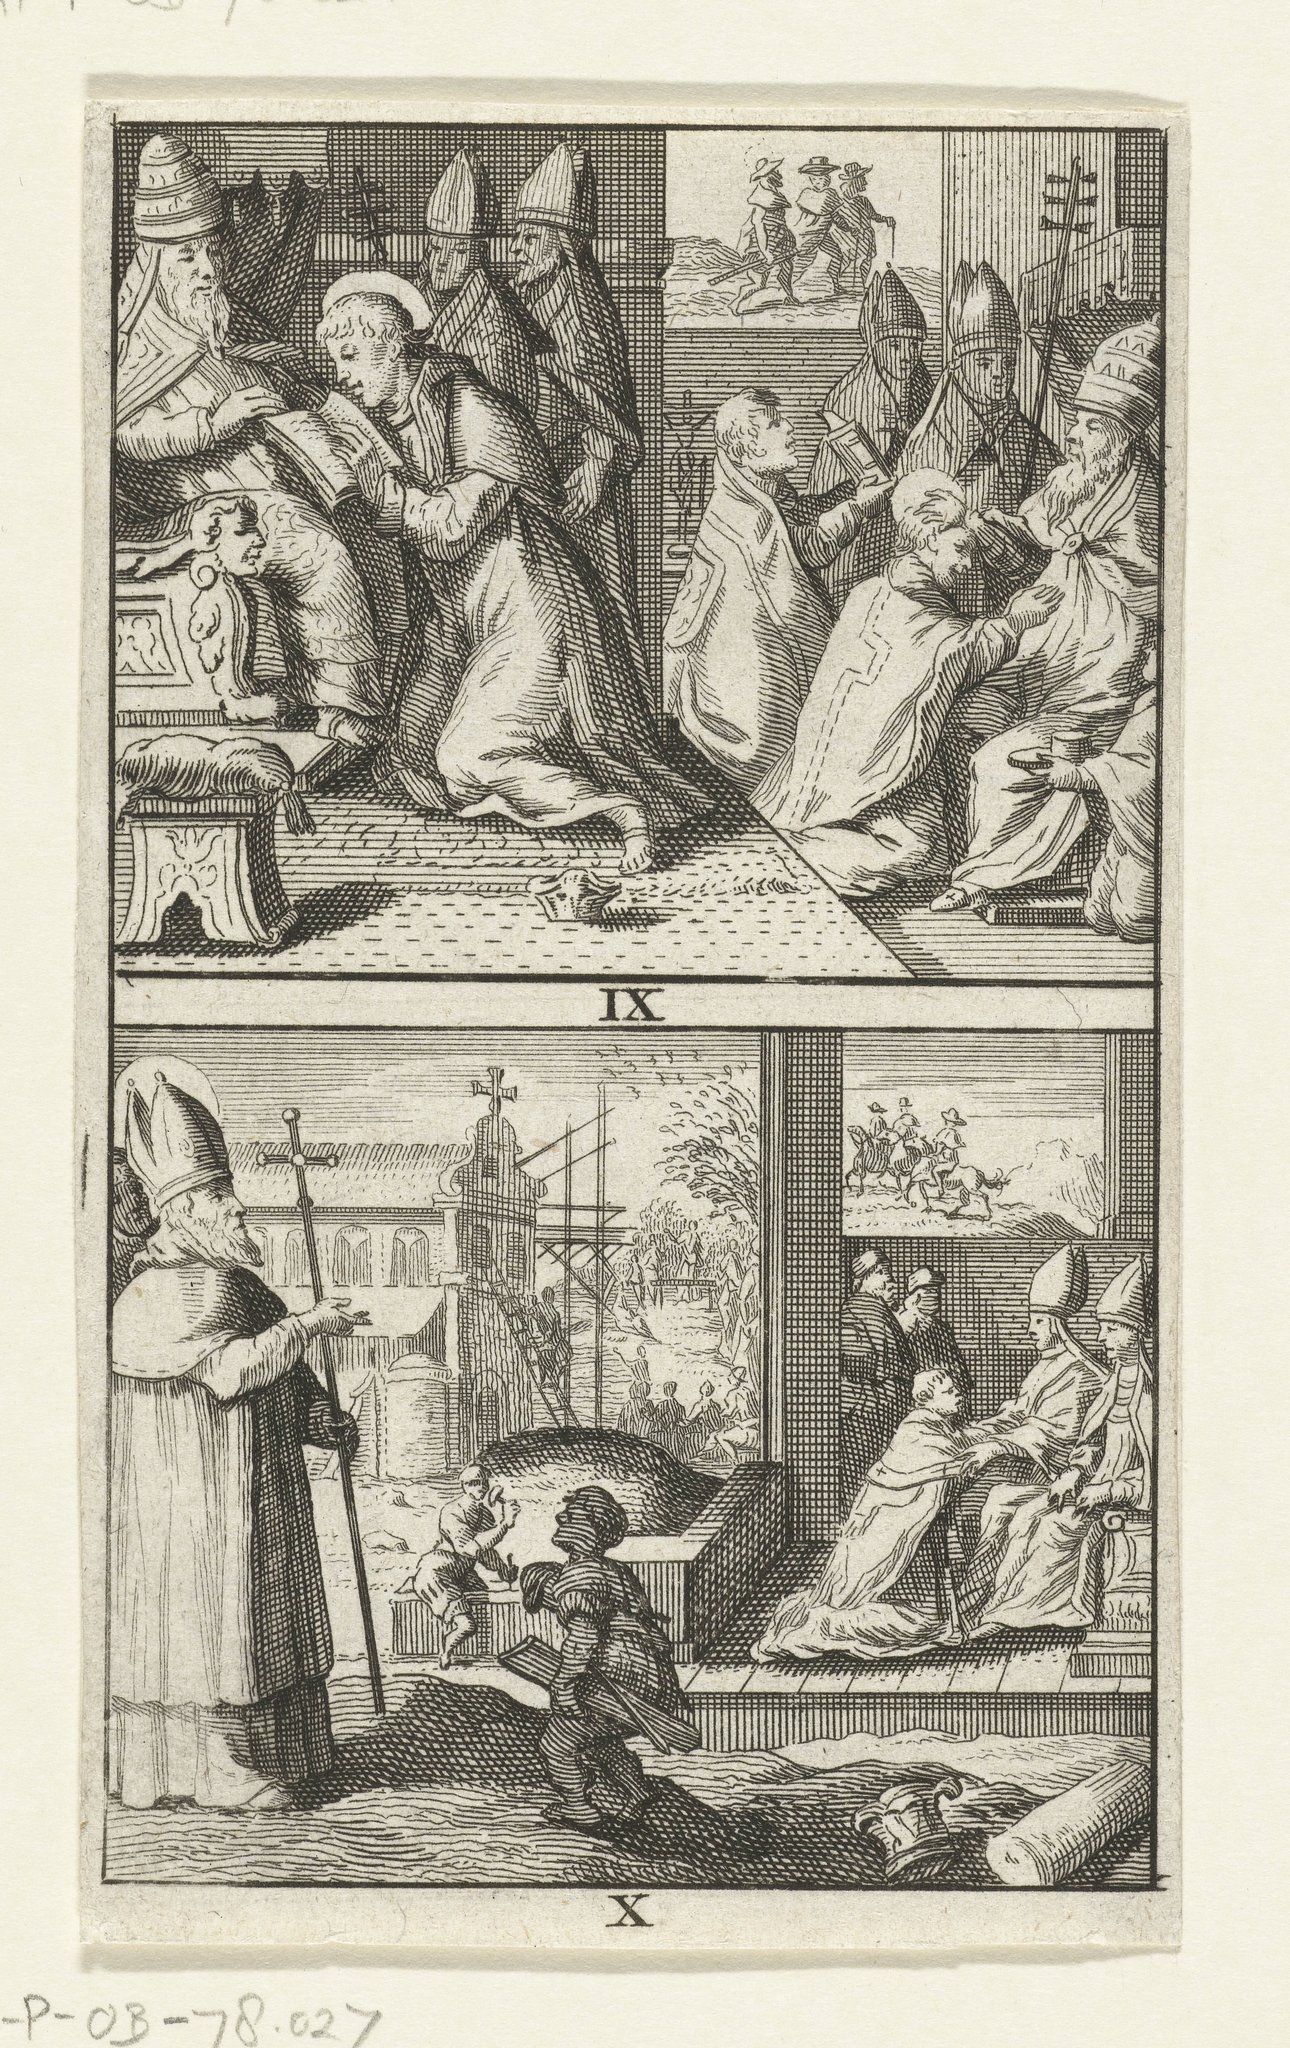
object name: print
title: Scènes uit het leven van de heilige Bonifatius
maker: Anonymous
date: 1640-1659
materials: paper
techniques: etching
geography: low countries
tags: the martyr boniface, 'apostle of germany', and archbishop of mainz; possible attributes: axe in root of tree, book pierced by a sword, fountain (springing up from under his staff), whip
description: Scènes uit het leven van de heilige Bonifatius, platen IX en X. De heilige tussen pausen en bij de bouw van een kerk. Zesde prent in een serie prenten over het leven van de heilige Bonifatius, bestaande uit een grote afbeelding van de heilige gevolgd door 8 platen met telkens twee kleinere genummerde voorstellingen onder elkaar.